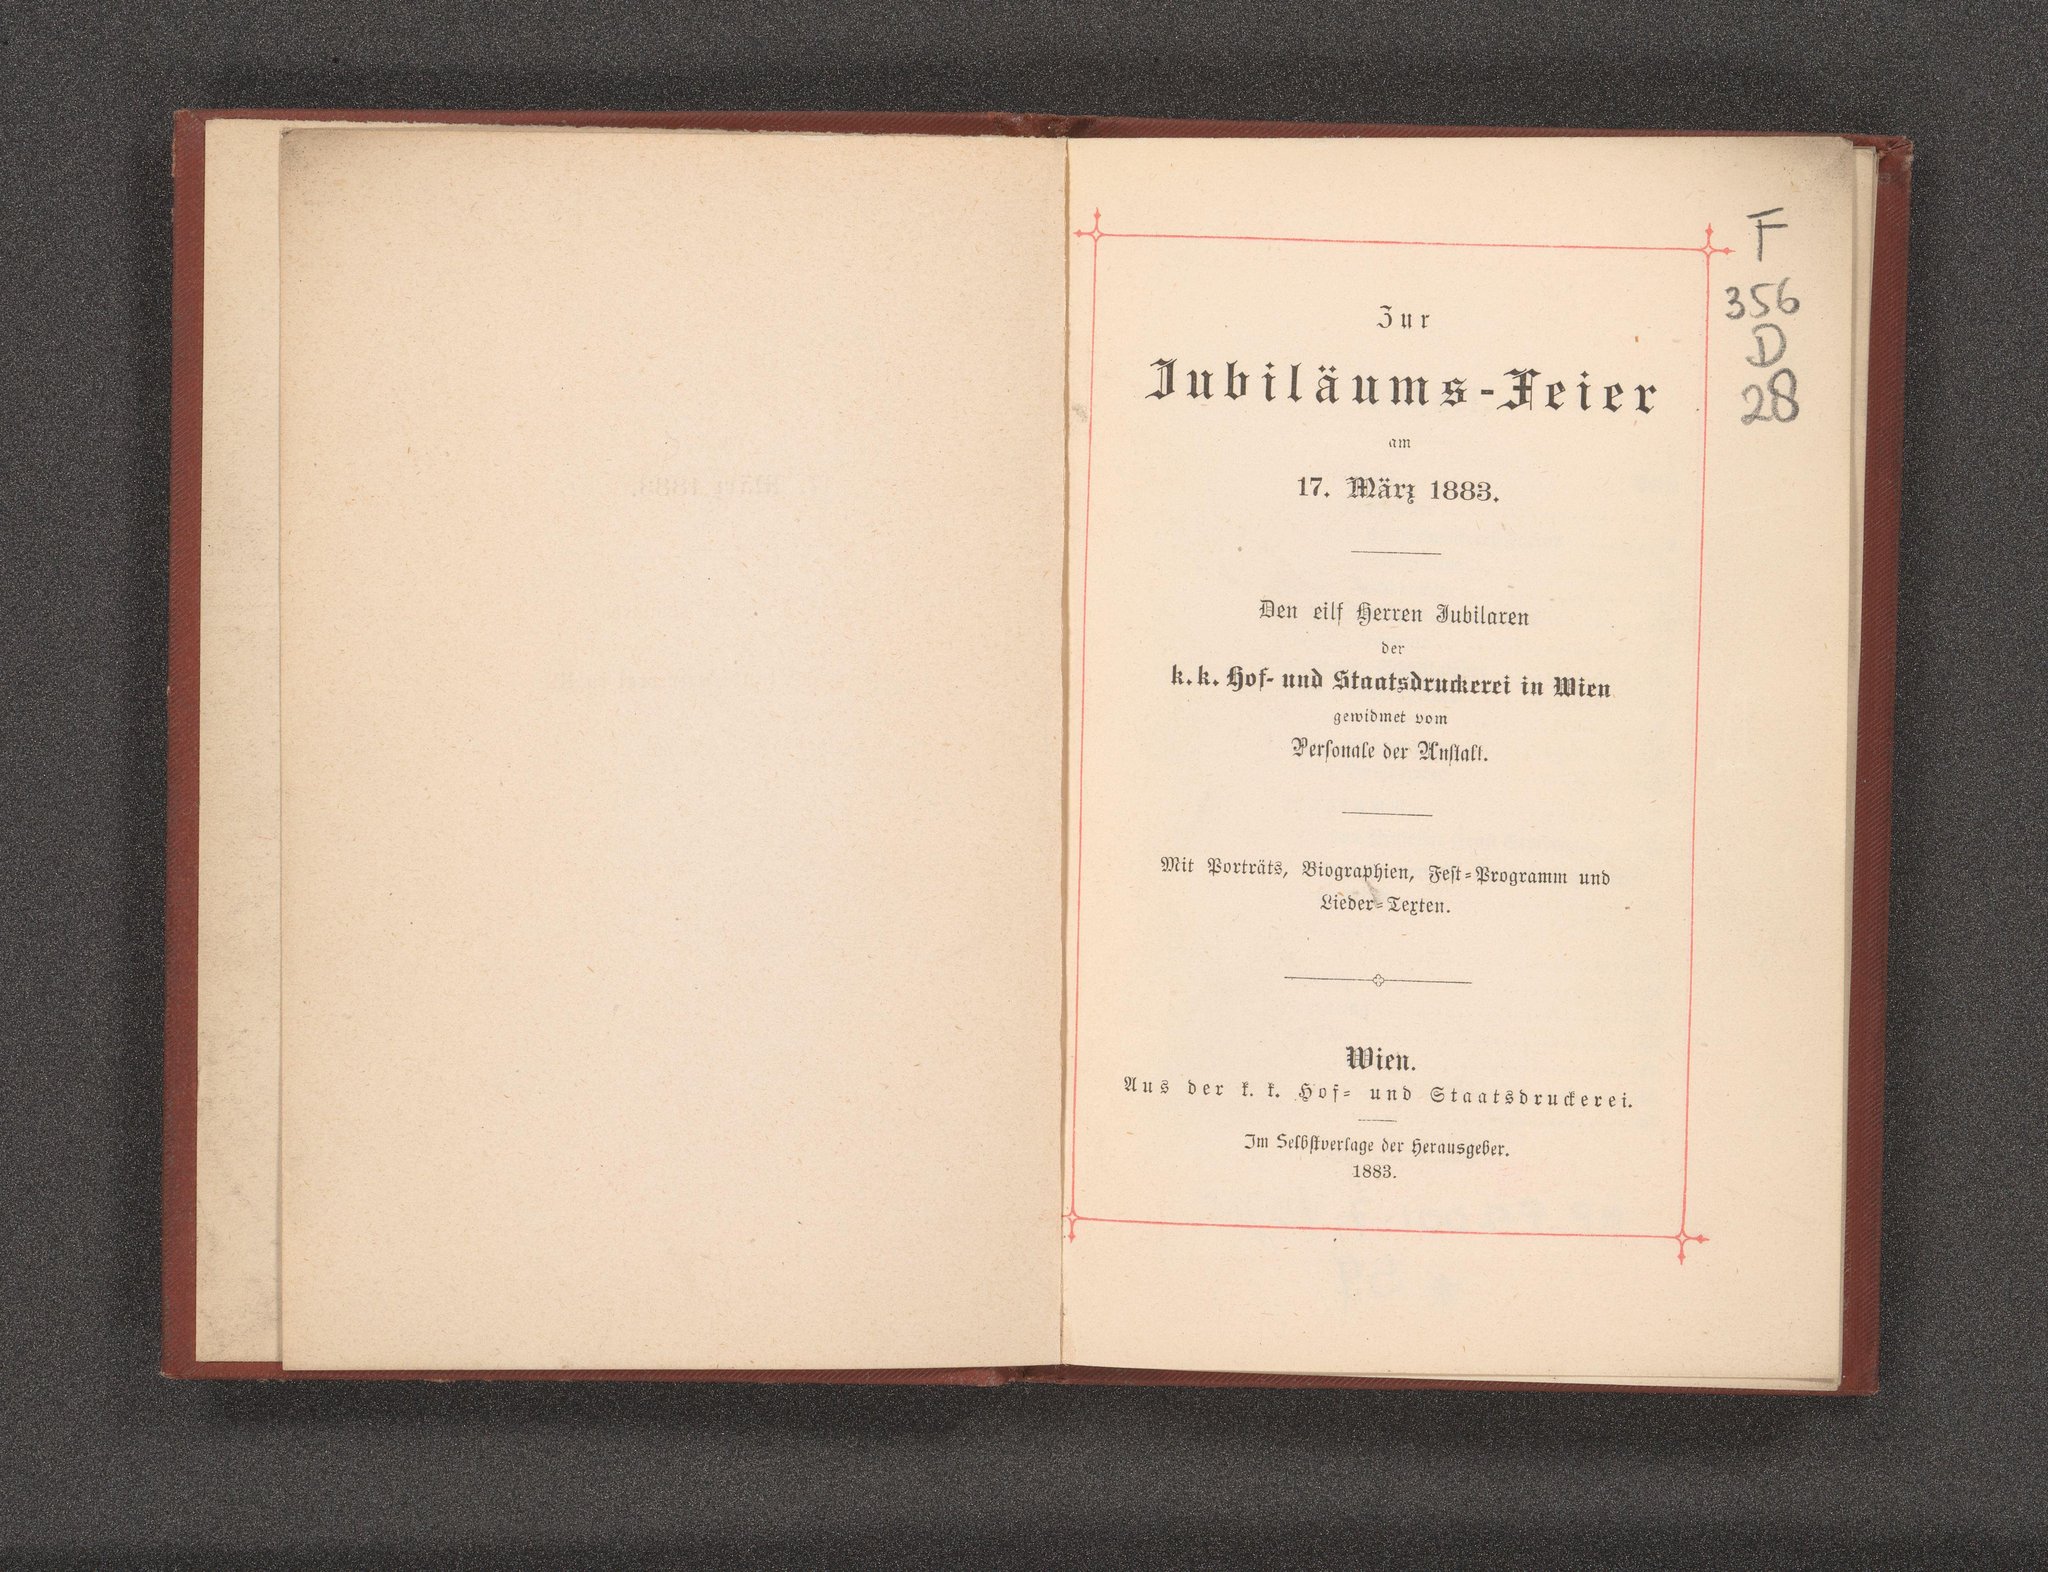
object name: book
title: Zur Jubiläums-Feier am 17. März 1883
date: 1883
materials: linen, paper, photographic support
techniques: albumen print, printing